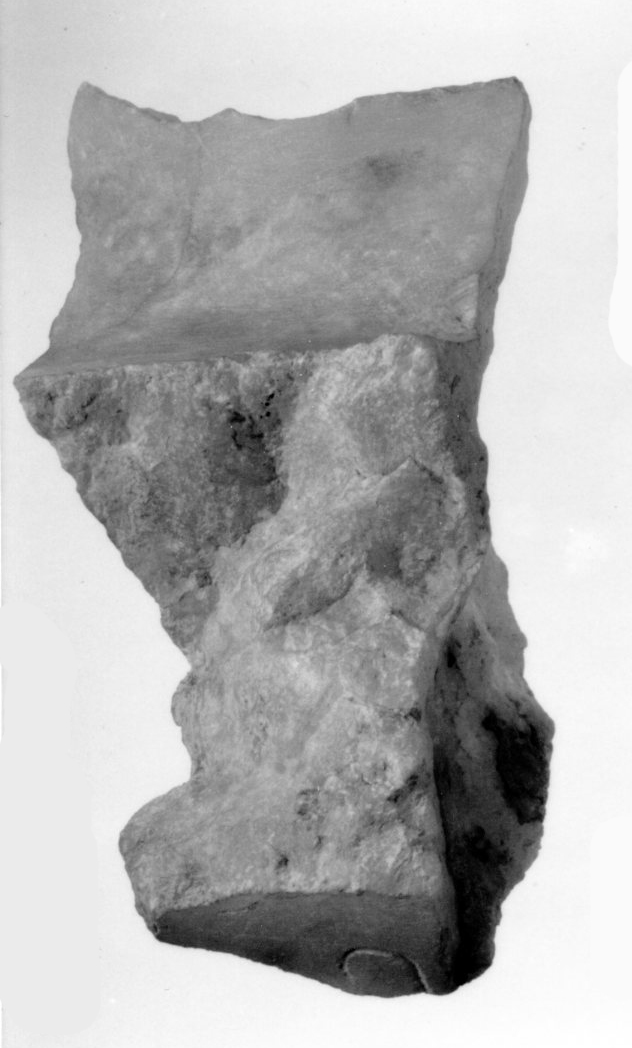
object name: canopic box, siptah, top surface, inner surface, jar lip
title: Fragment of the Top and Side Surfaces of Siptah's Canopic Chest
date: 1194-1188 BCE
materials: stone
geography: egypt